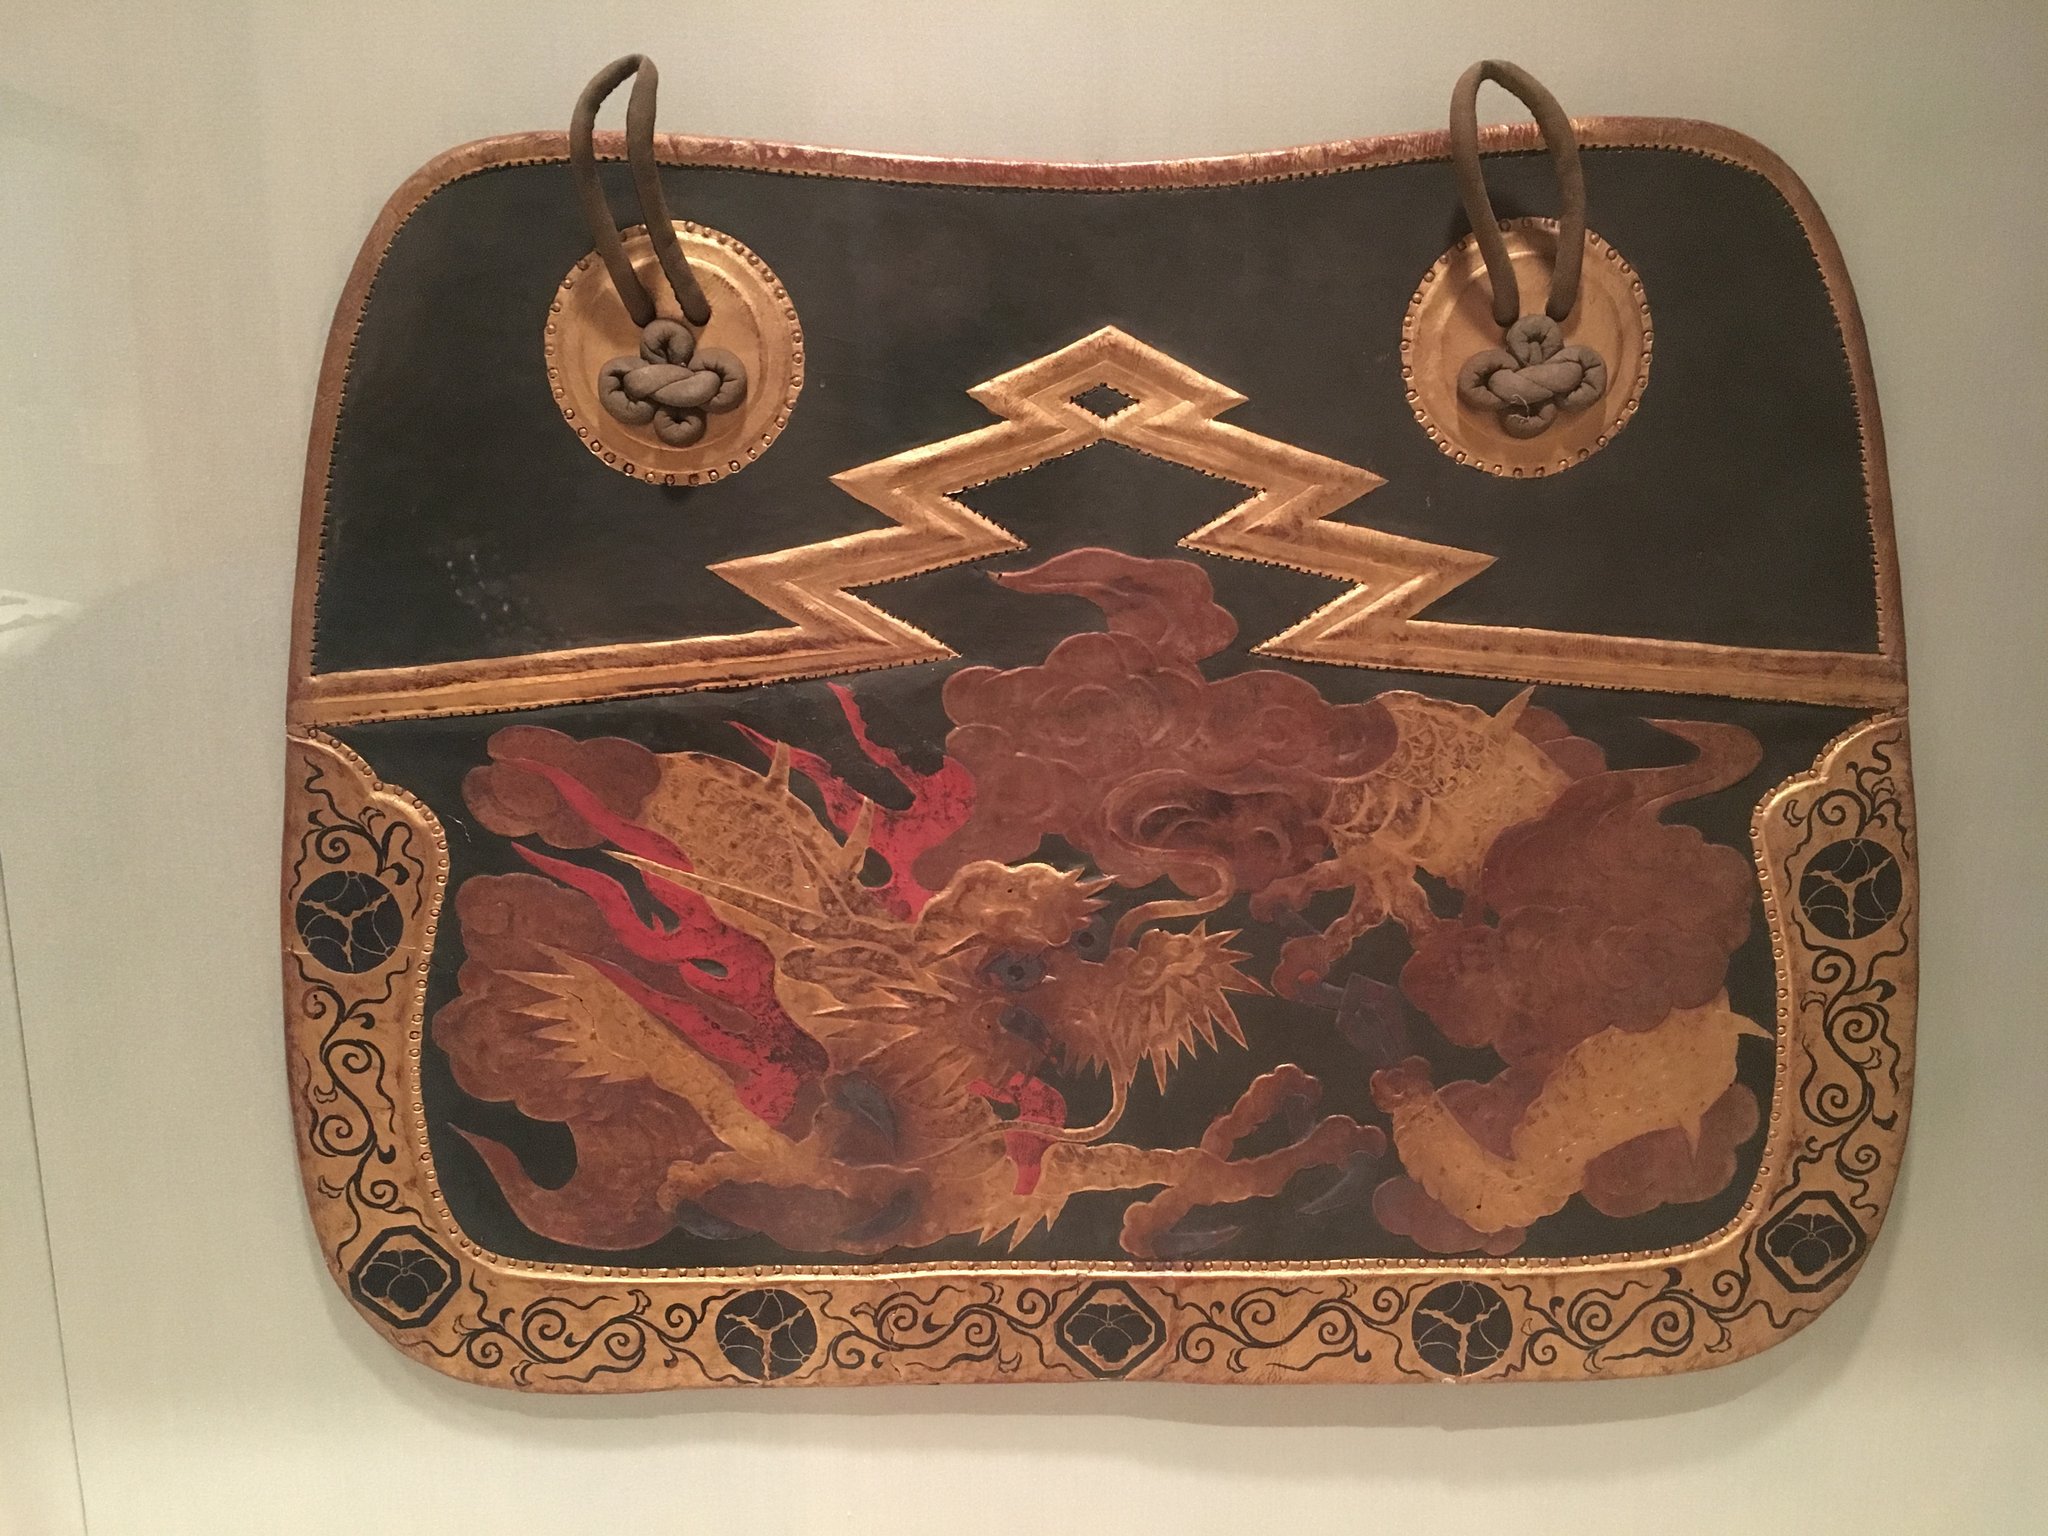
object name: saddle flap i aori i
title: Two Saddle Flaps (Aori)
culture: japanese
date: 1701-1800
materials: gold, leather, pigment, silk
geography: japan